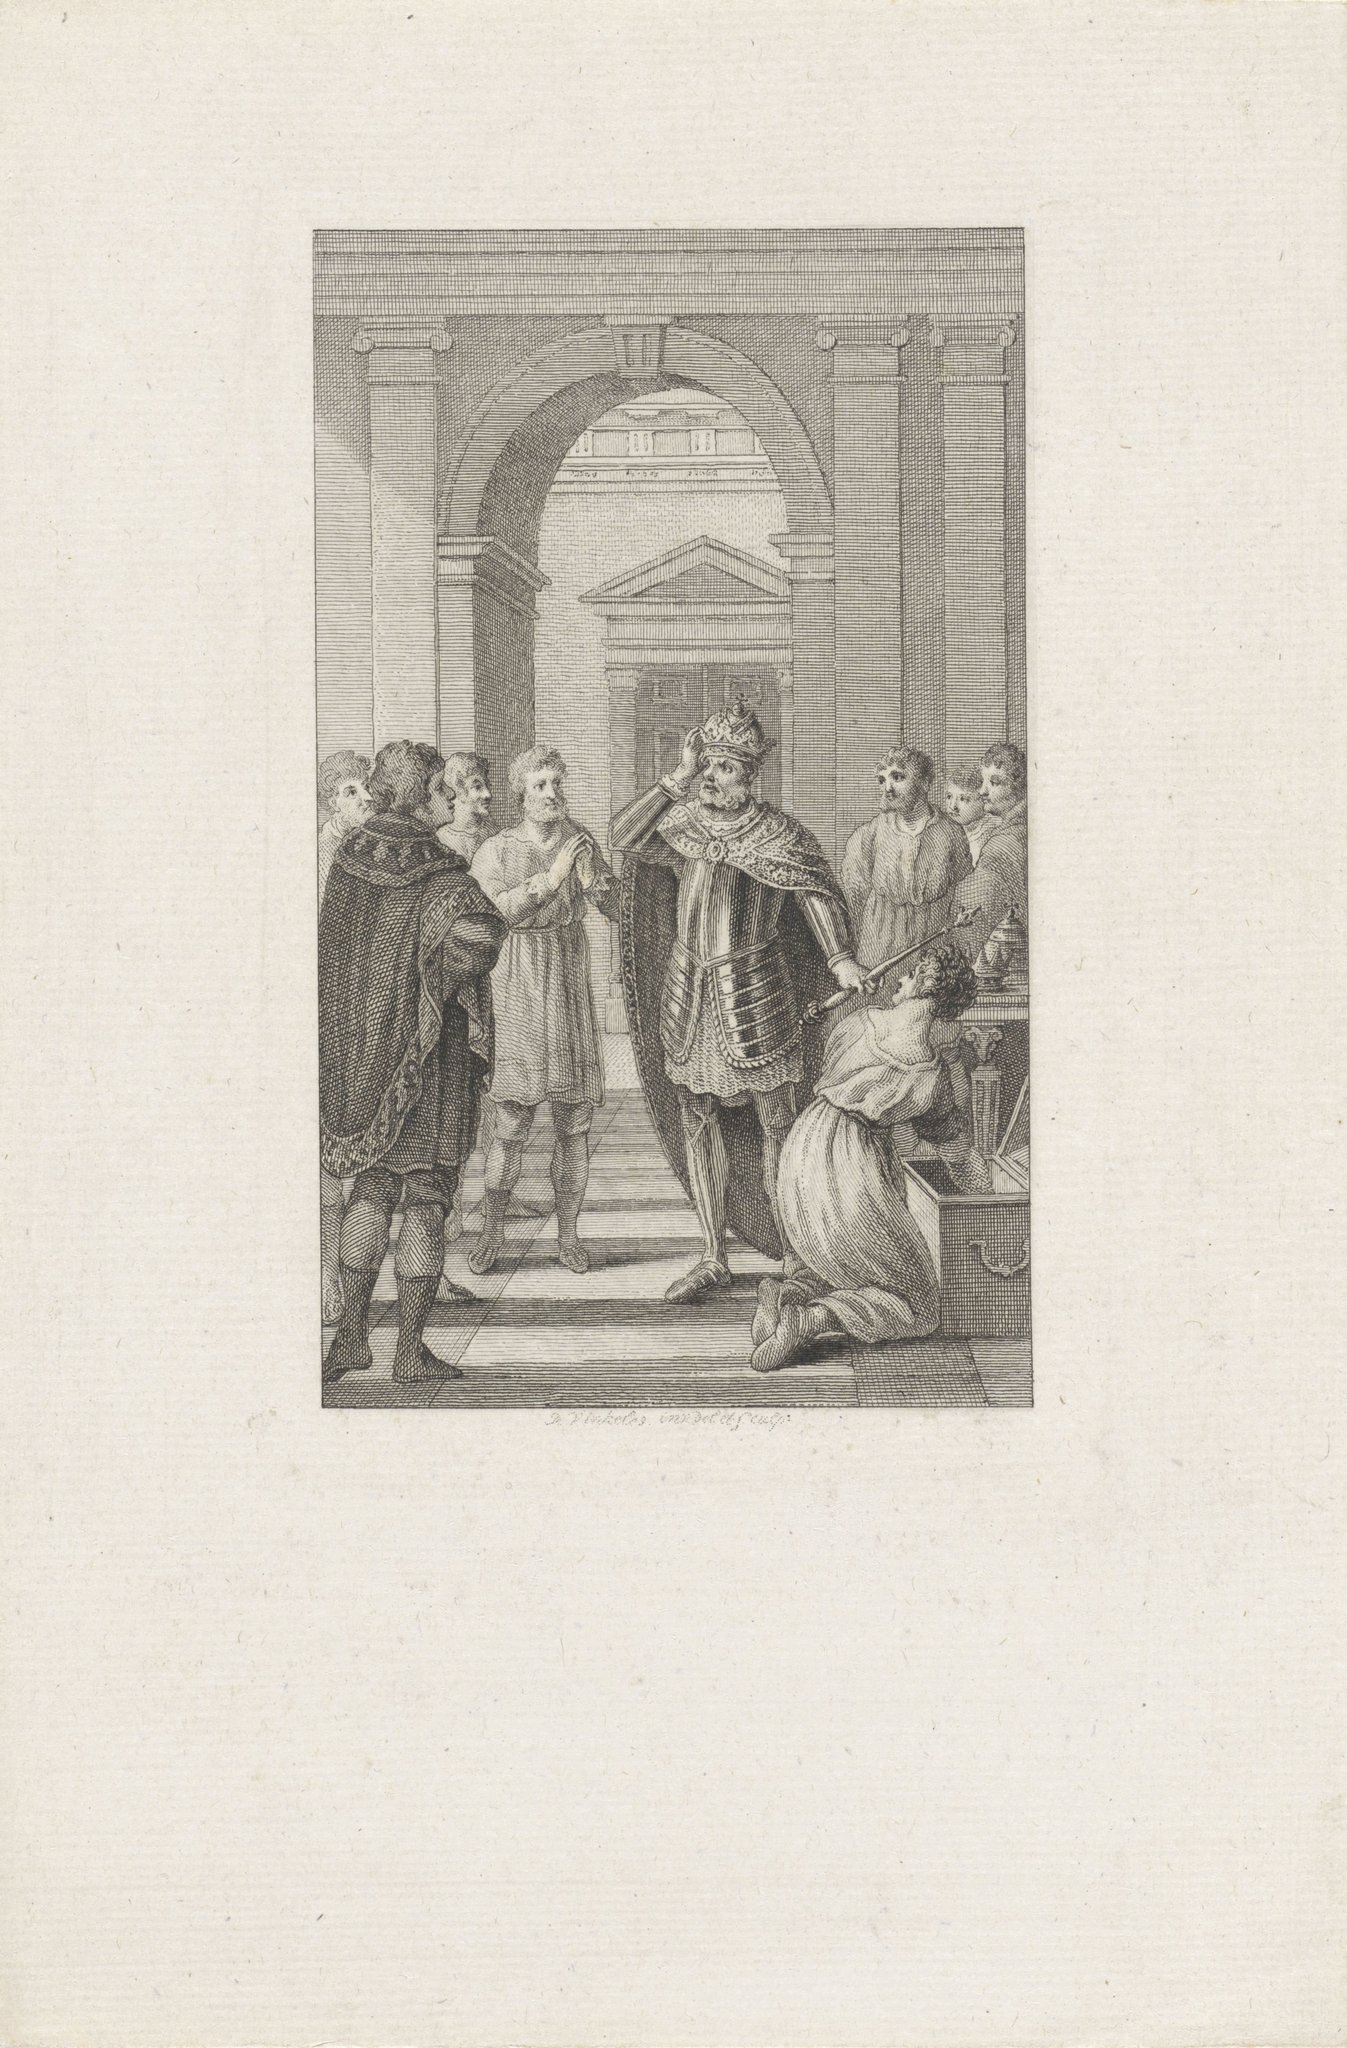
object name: print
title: Keizer Frederik II grijpt naar zijn kroon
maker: reinier vinkeles (i)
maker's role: draughtsman, print maker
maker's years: 1741-1816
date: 1808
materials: paper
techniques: engraving, etching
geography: amsterdam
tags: crown (symbol of sovereignty)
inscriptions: collector's mark: Lugt 2228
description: Proefdruk van illustratie in: Hamelsveld, Ysbrand van. Algemeene kerkelijke geschiedenis, der Christenen, deel 16. Haarlem: François Bohn, 1808, p. 257.